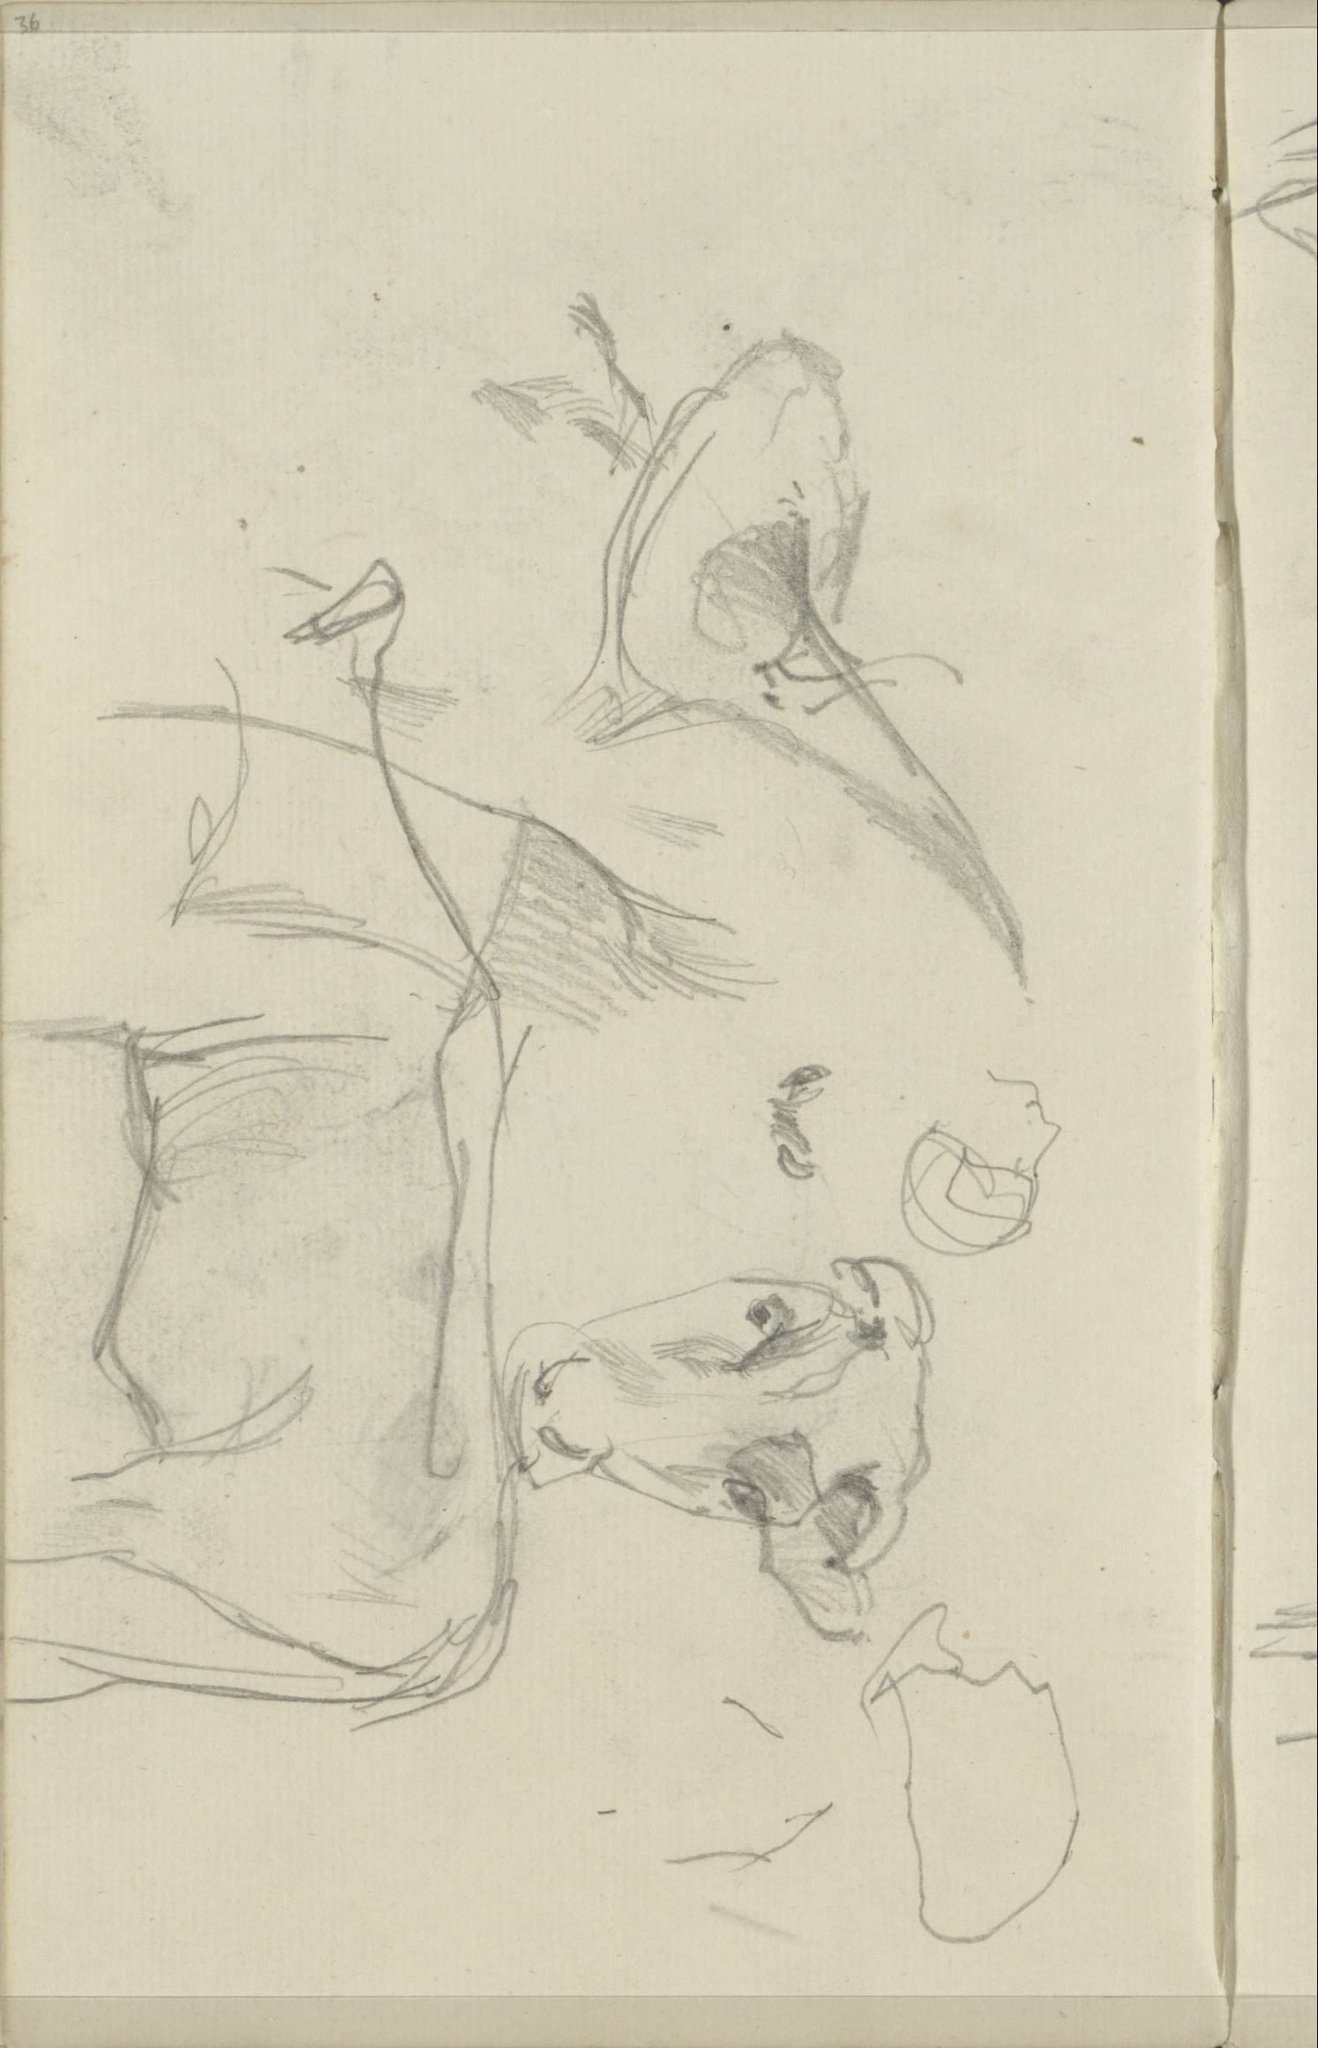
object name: sketchbook leaf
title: Studieblad met koeien, een vogel en een hoofd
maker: george hendrik breitner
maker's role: draughtsman, painter, print maker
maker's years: 1857-1923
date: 1880-1882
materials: paper, pencil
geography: the hague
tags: head (human), cow, birds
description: Pagina 36 uit een schetsboek met 25 bladen.